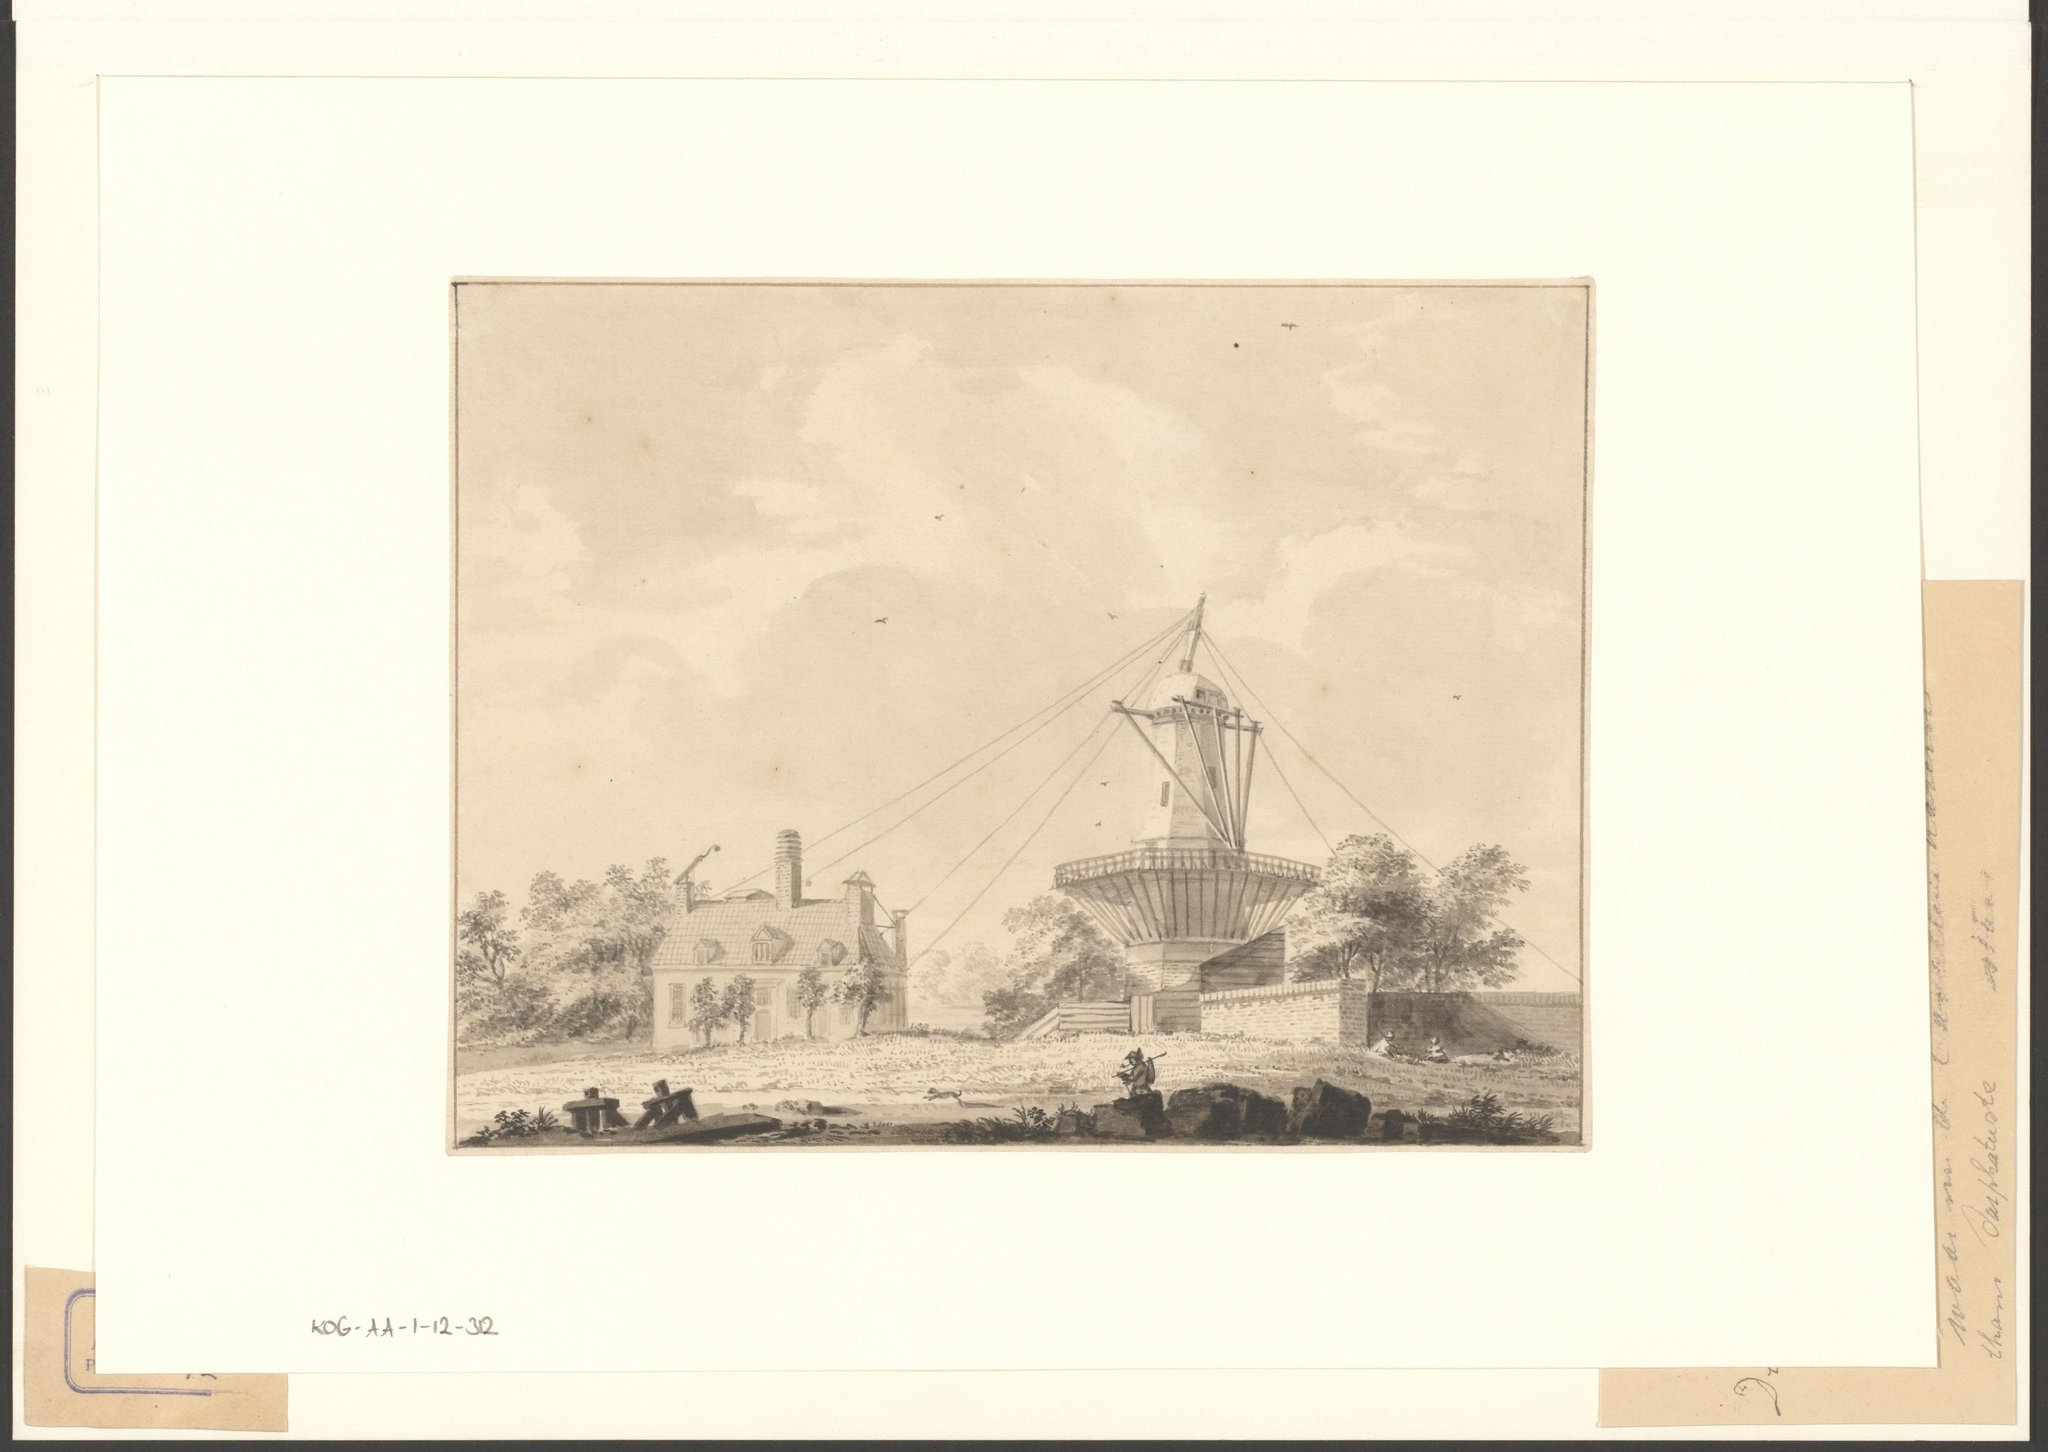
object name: drawing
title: Gezicht op het bolwerk Muiden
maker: gerrit lamberts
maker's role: bookseller, draughtsman, print maker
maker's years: 1776-1850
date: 1786-1850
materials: ink, paper, pencil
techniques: brush, pen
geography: amsterdam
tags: city-view in general; 'veduta', windmill in landscape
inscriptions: inscription: ‘N8 / De Moole (...) thans Sarphatistr s[...]’, inscription: ‘Port. 12-312’, collector's mark: ‘12’ Lugt 1641b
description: Onderwerpsrubriek binnen de Atlas Amsterdam: Sarphatistraat, Schans.